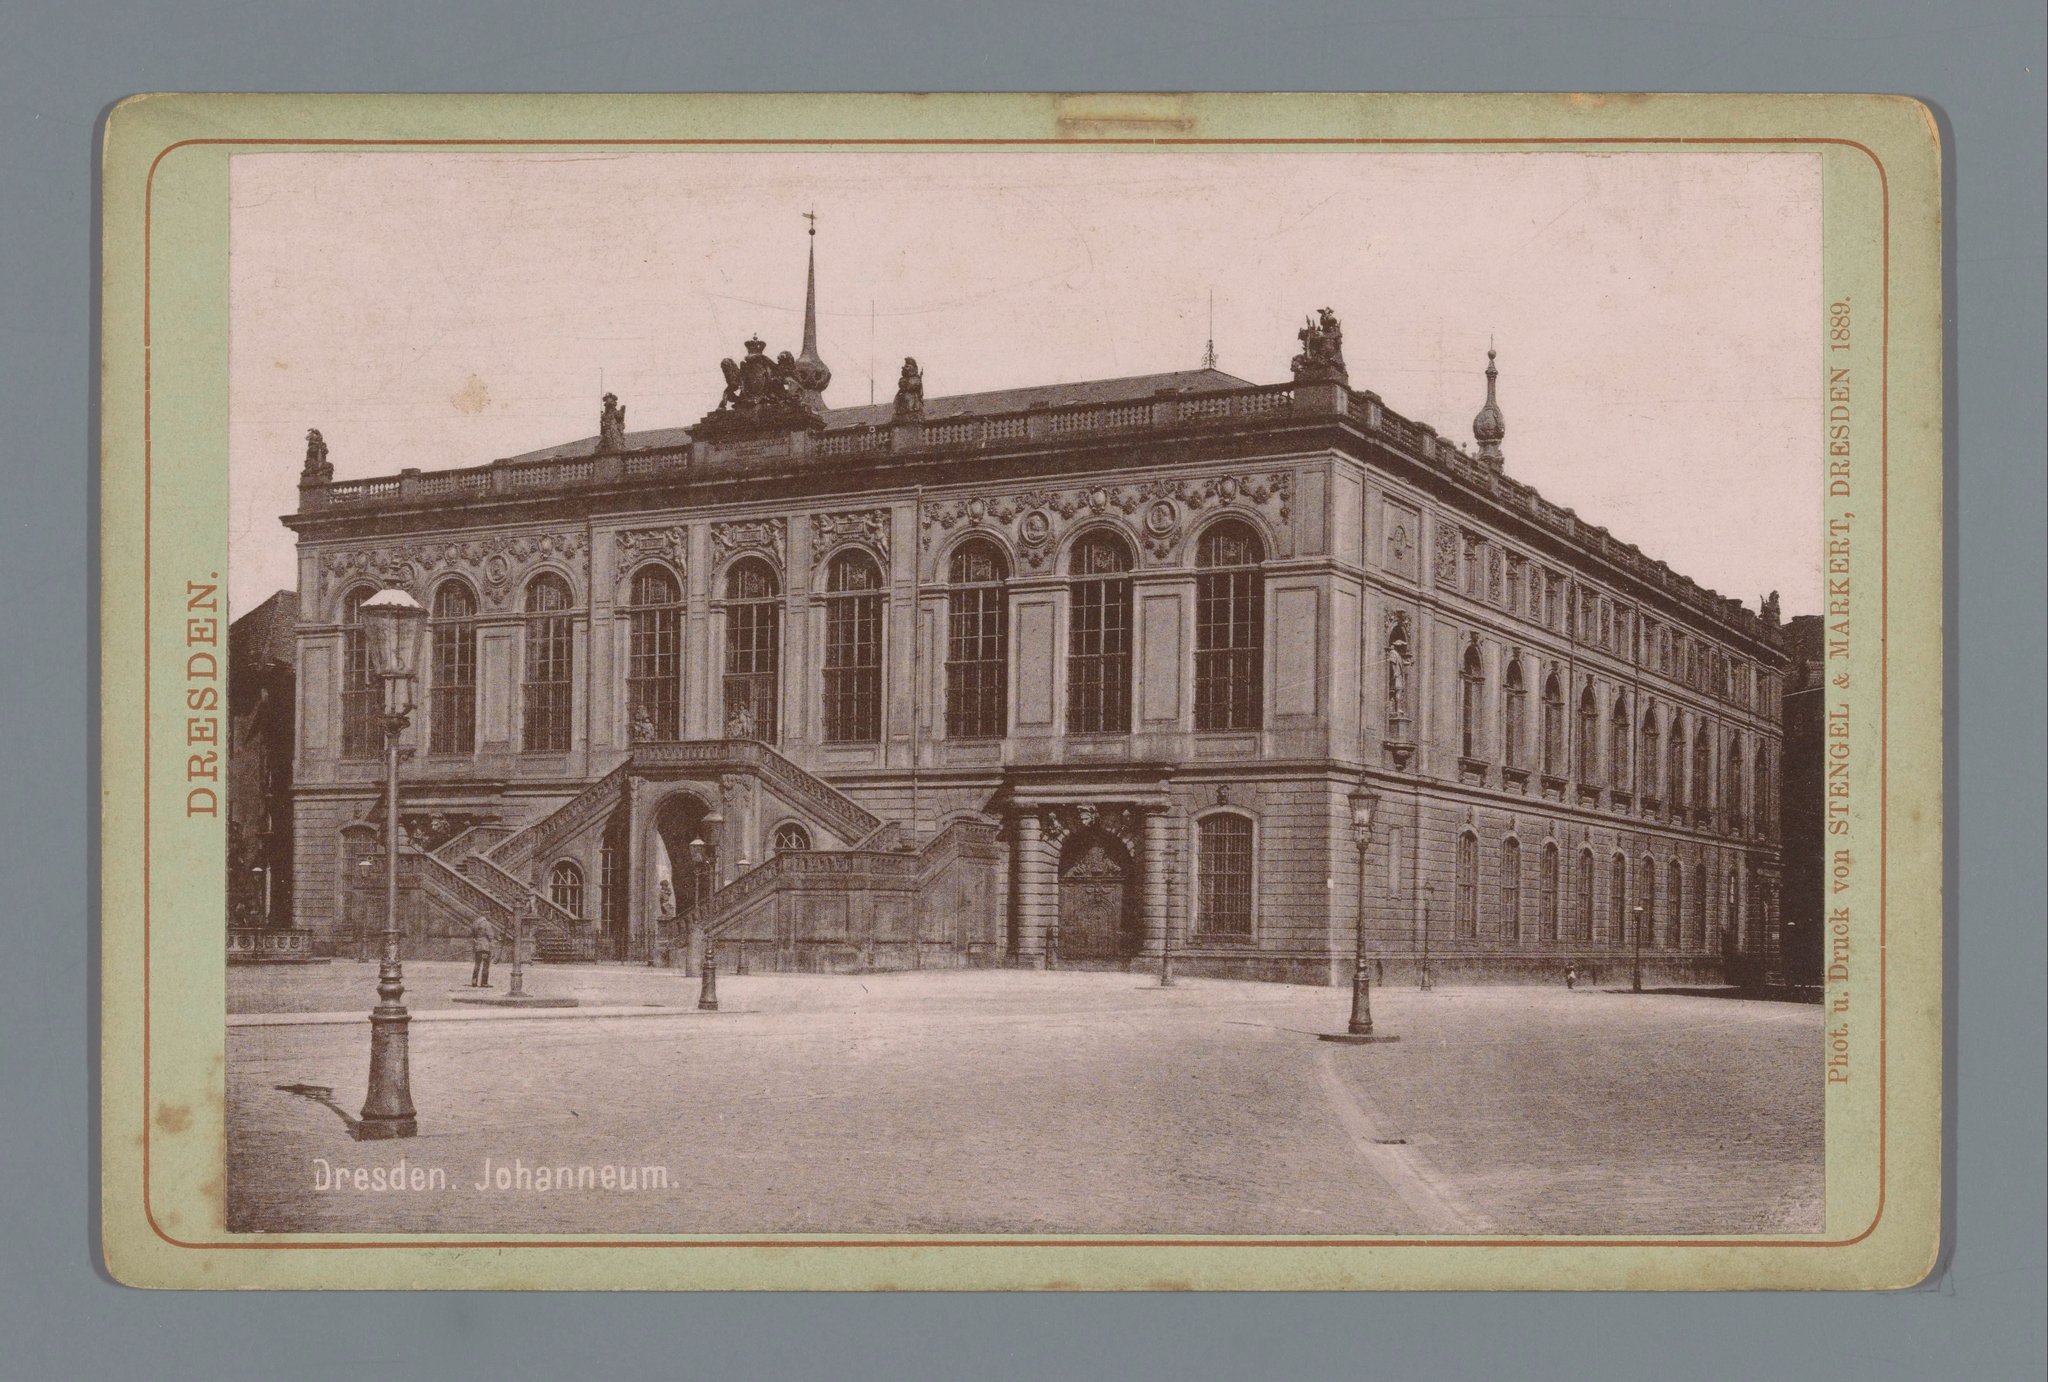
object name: photomechanical print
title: Johanneum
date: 1889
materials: cardboard, paper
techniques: photograph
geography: dresden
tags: permanent exhibition, museum, stall, stable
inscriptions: date